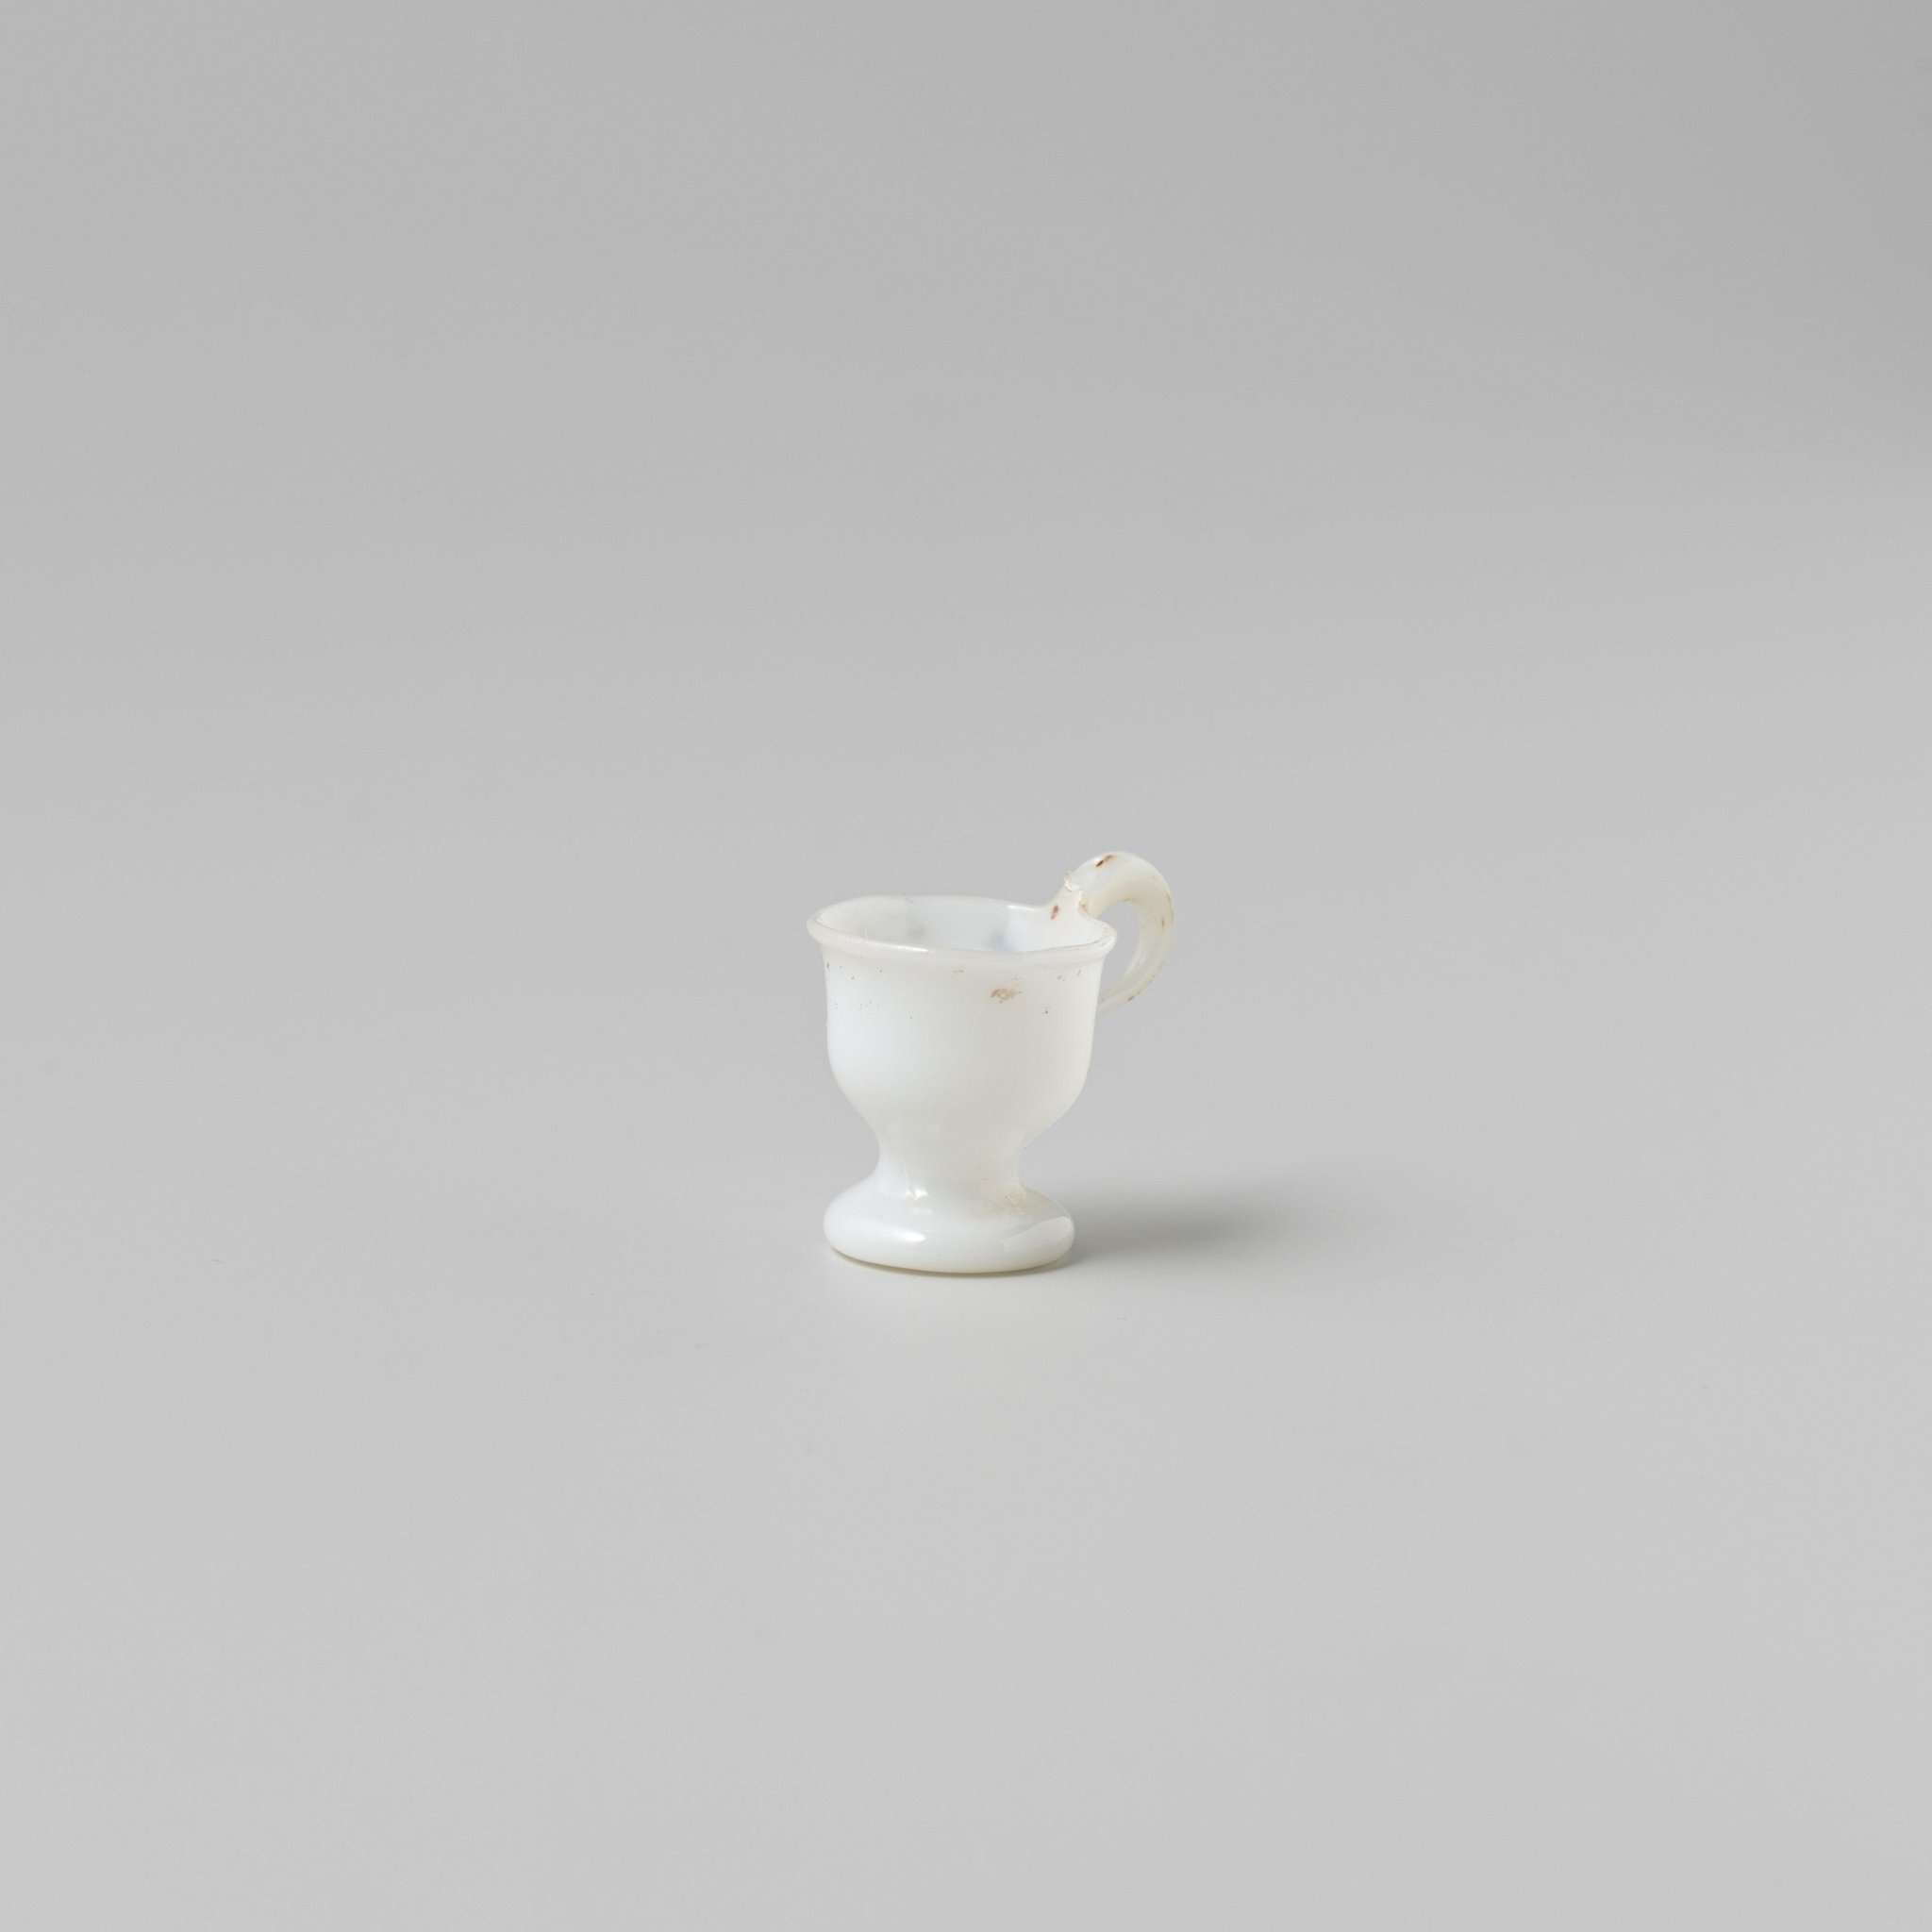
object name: cup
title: Kop met oor, beschilderd met bloem in wit, rood en groen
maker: Anonymous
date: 1800-1849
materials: glass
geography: bristol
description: Kop van opaak wit glas, bol model op voet, met s-vormig oor. De kop is beschilderd met een bloem in wit, rood en groen.